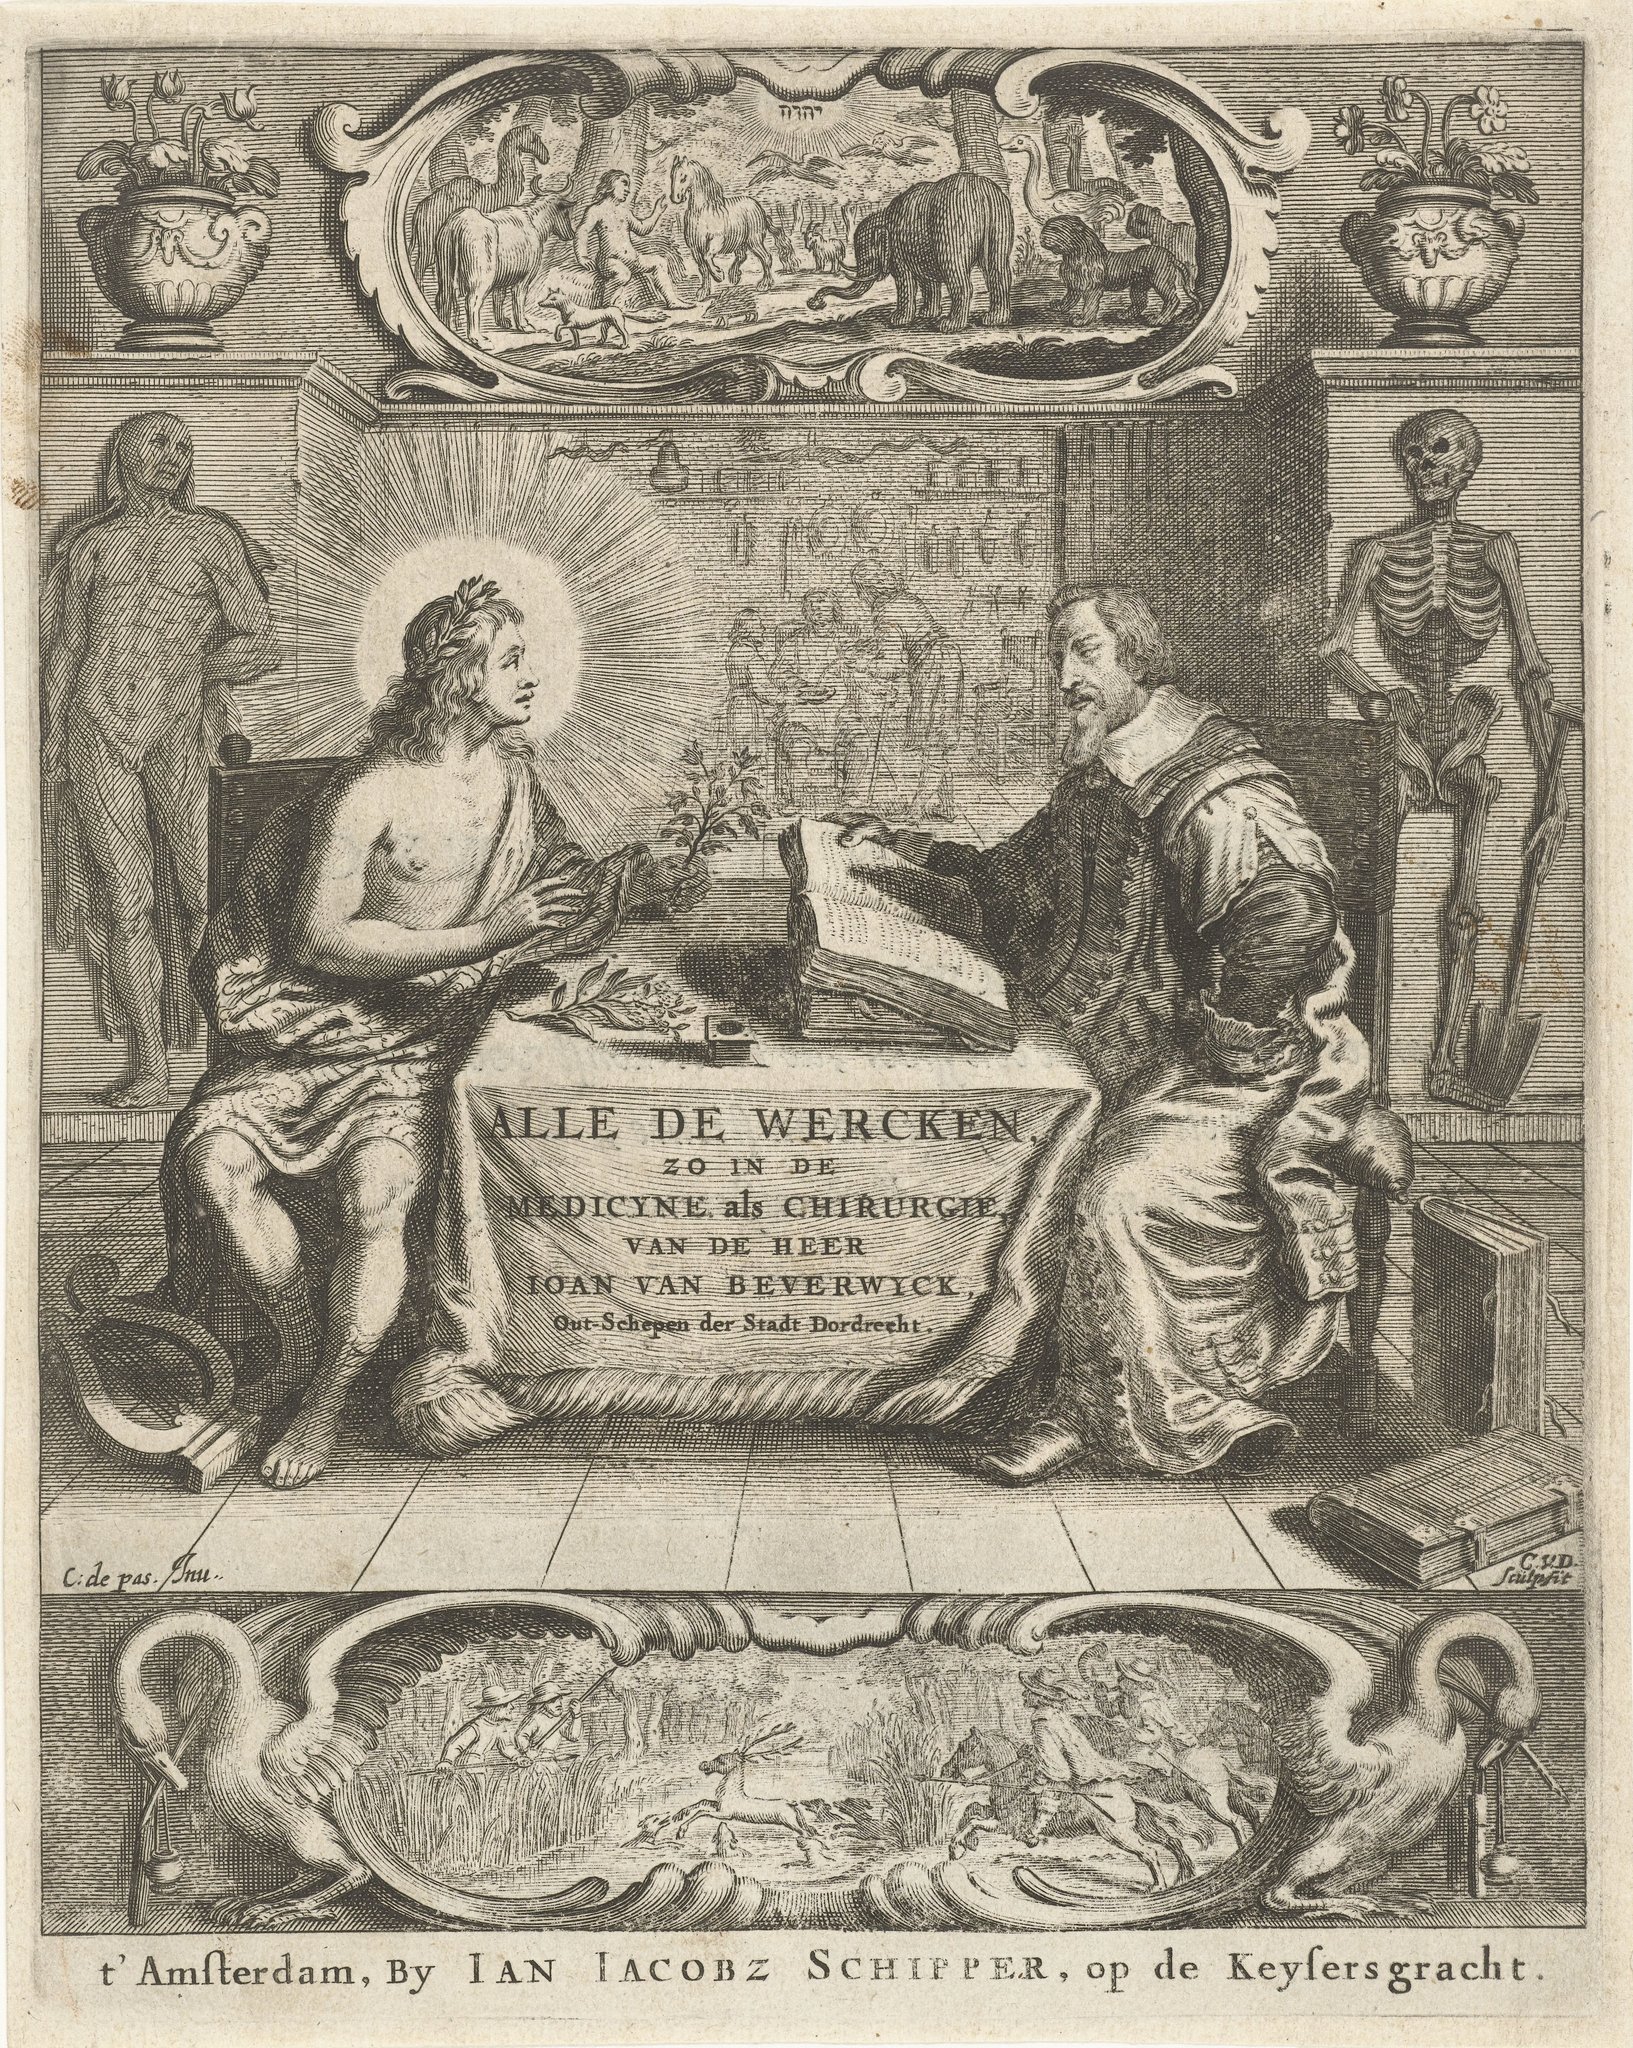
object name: print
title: Alle de wercken, zo in de medicyne als chirurgie van de heer Ioan van Beverwyck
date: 1612-1656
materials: paper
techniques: engraving, etching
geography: amsterdam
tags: stag-hunting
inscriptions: collector's mark: Lugt 2228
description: Geneesheer Johan van Beverwijk bestudeert boeken en zit met Apollo aan tafel in interieur met op de wand voorstelling van medische ingreep: een aderlating. In cartouche boven Adam in het paradijs en cartouche onder hertenjacht geflankeerd door twee zwanen met gespreide vleugels.